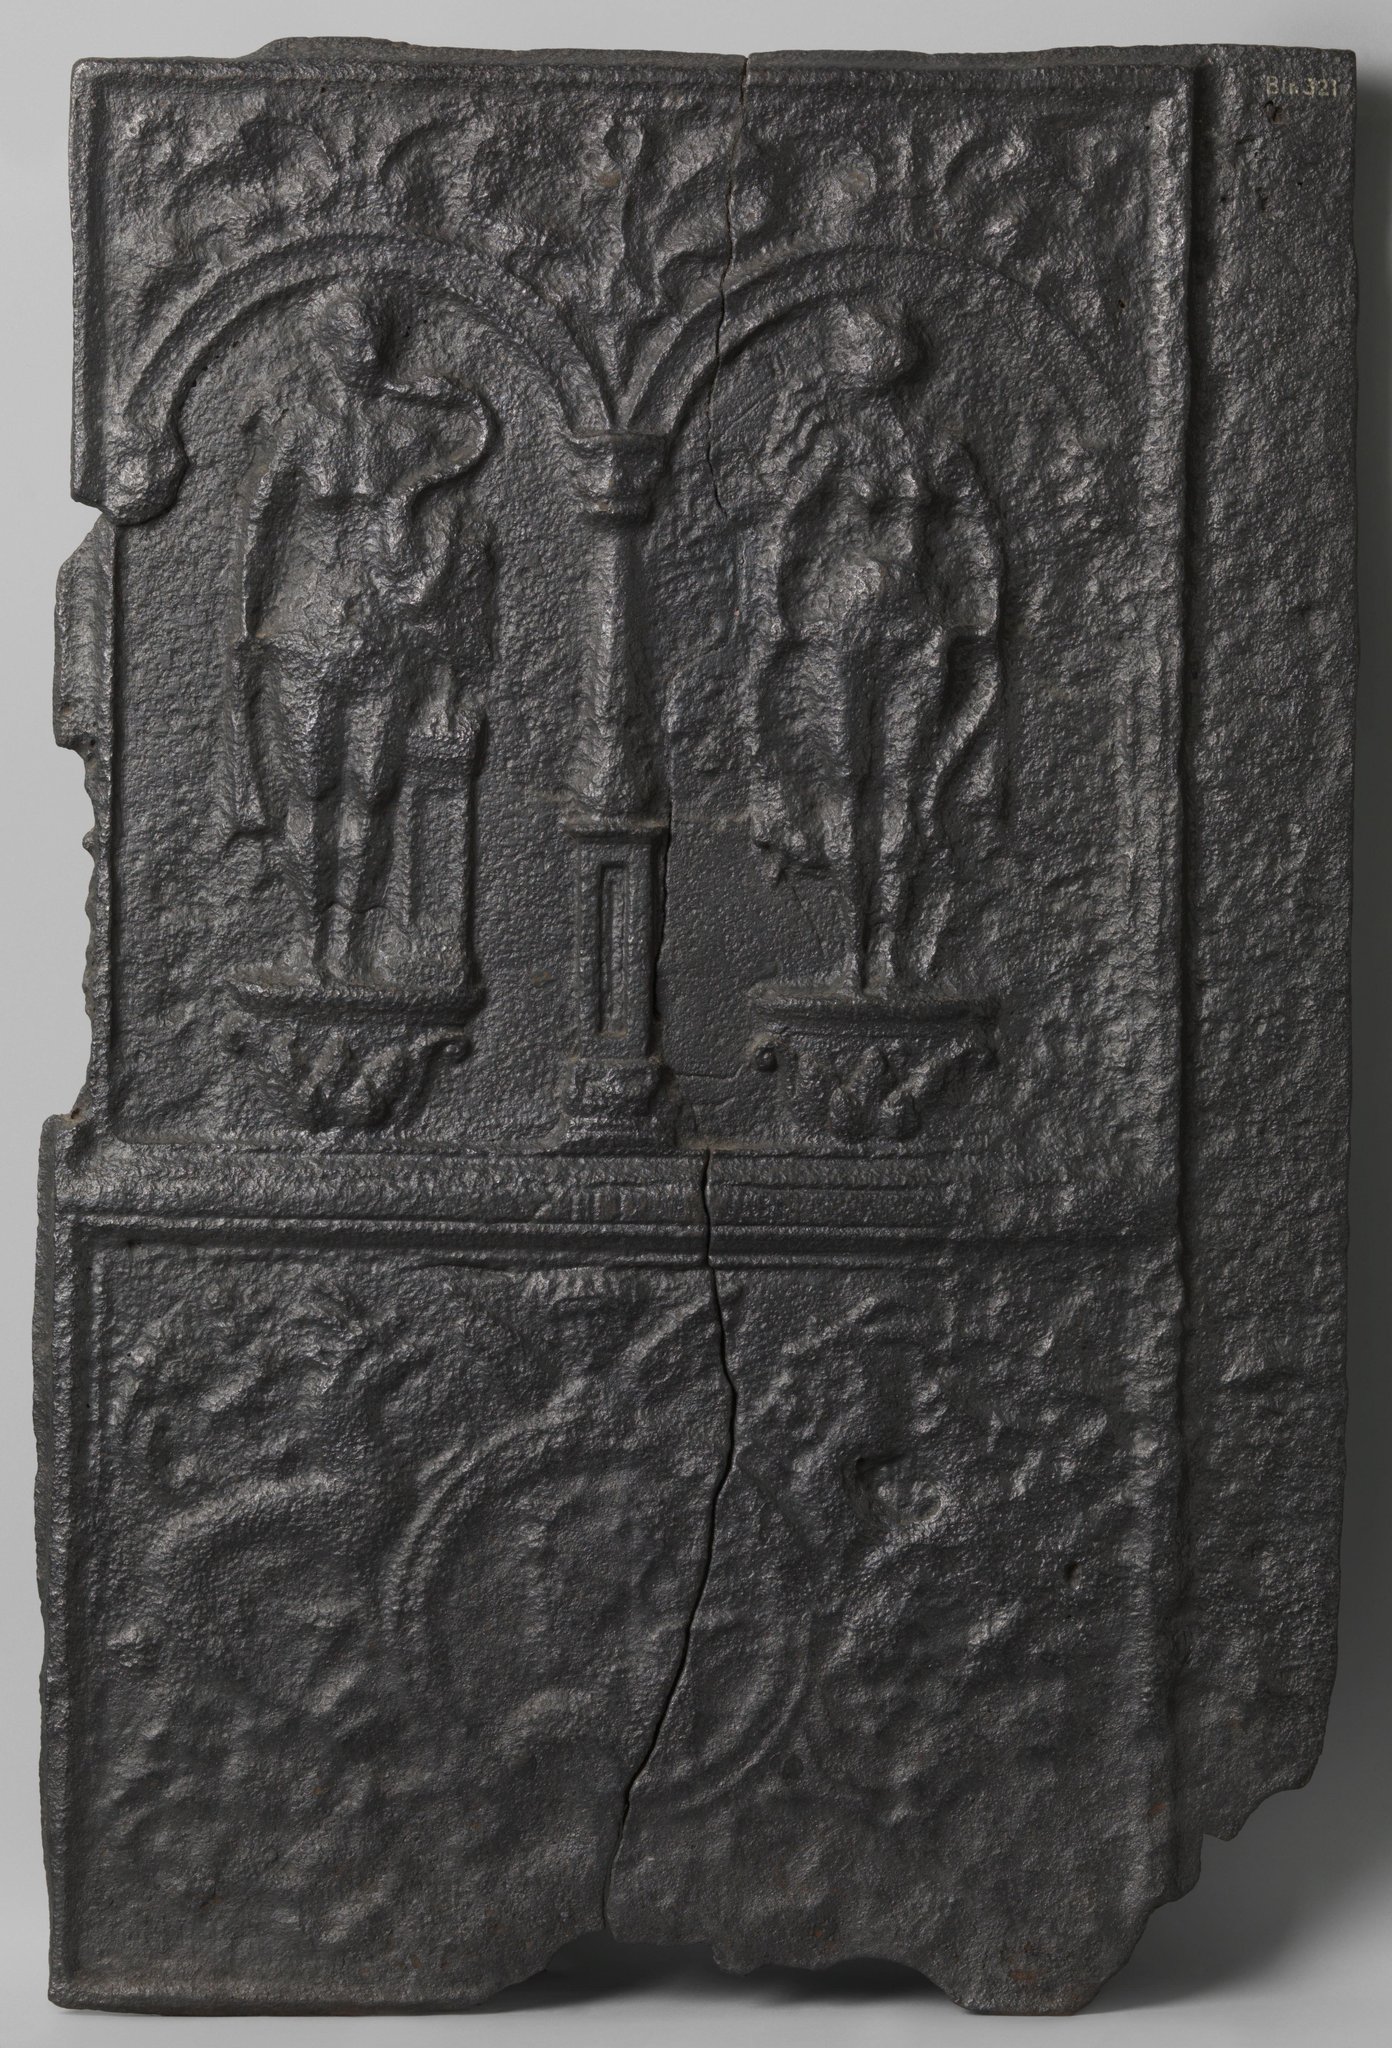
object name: stove plate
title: Kachelplaat met twee vrouwenfiguren, Leda en Fortuna (?)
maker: Anonymous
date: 1550-1600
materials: iron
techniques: casting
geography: germany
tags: jupiter, in the shape of a swan, and leda, fortuna as roman personification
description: Kachelplaat van gietijzer, verdeeld in twee zones. In de bovenste zone onder bogen twee vrouwenfiguren op een console. Zij worden van elkaar gescheiden door een colonnet. De linkervrouw is Leda met de zwaan op een zuiltje naast haar. Rechts is mogelijk Fortuna. Boven de bogen bladornament. In de onderste zone een medaillon met buste en profil te midden van bladornament met fantasiewezens en erboven een gevleugelde engelenkop.